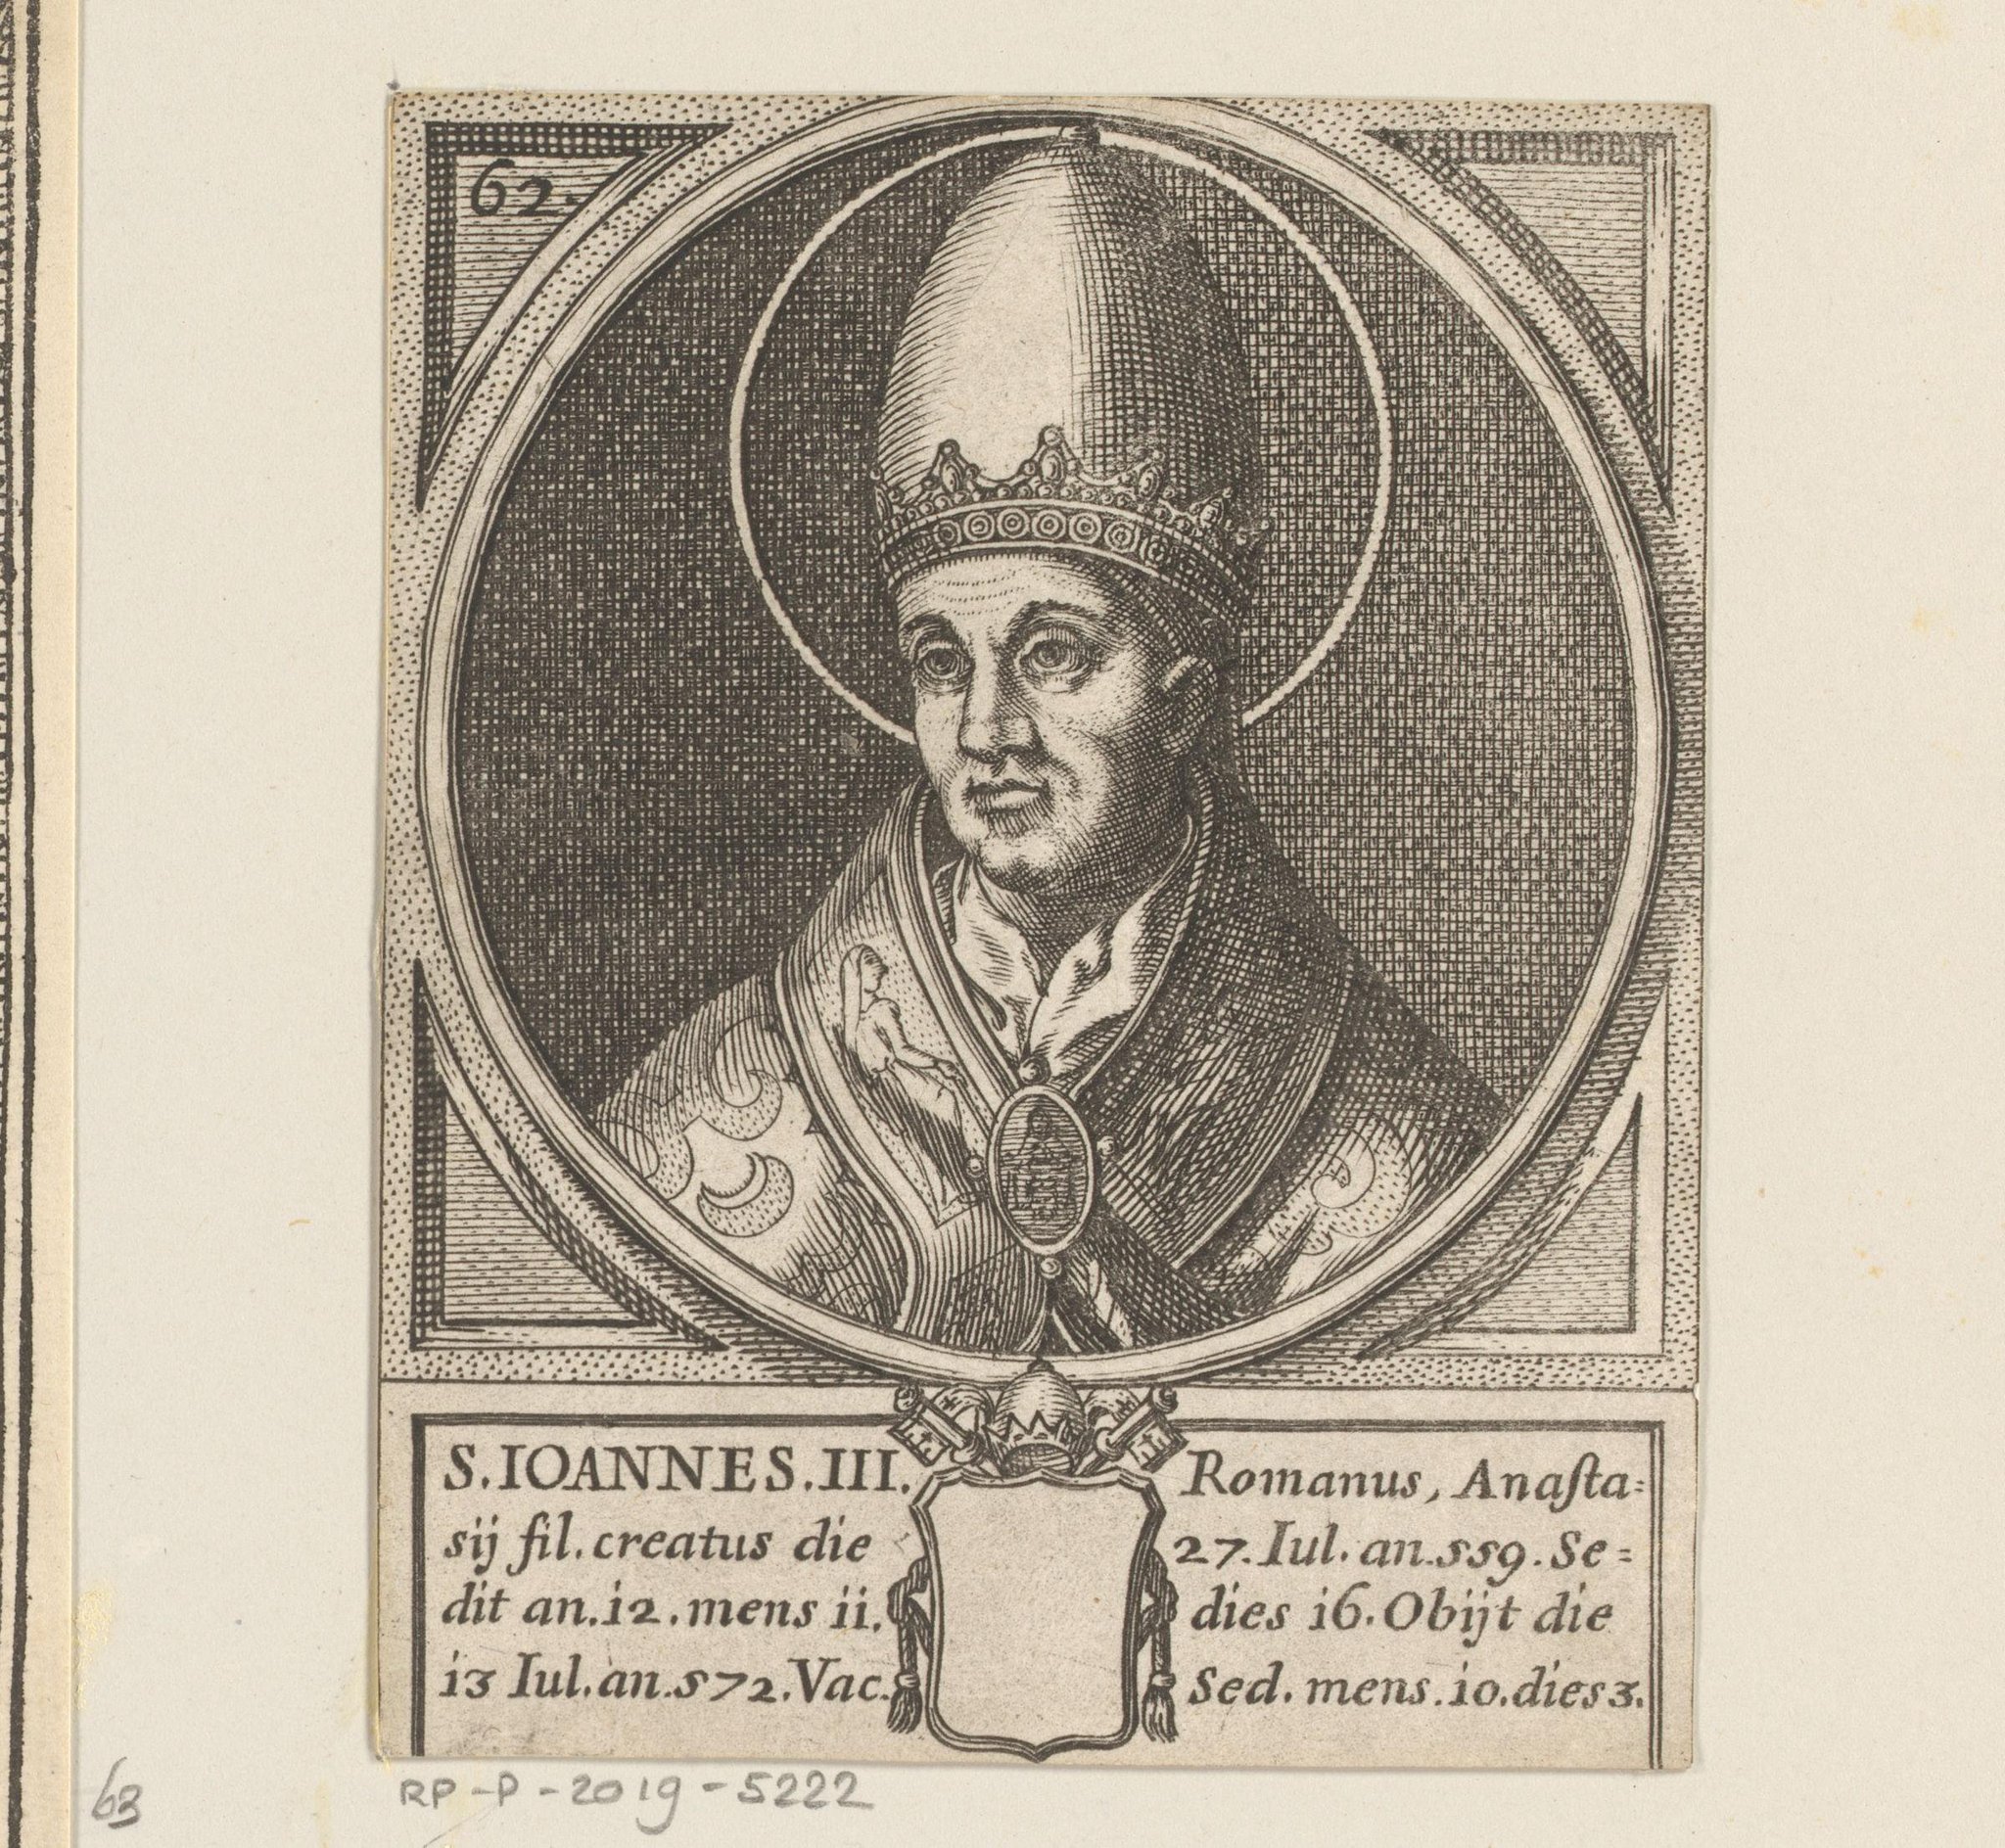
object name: print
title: Chronologische portretten van pausen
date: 1675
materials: paper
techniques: engraving, etching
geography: rome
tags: rome, historical persons, pope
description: Portret afkomstig uit een grote prent, bestaande uit 17 bladen die samengevoegd konden worden, uitgegeven door Giovanni Giacomo de' Rossi in 1675.